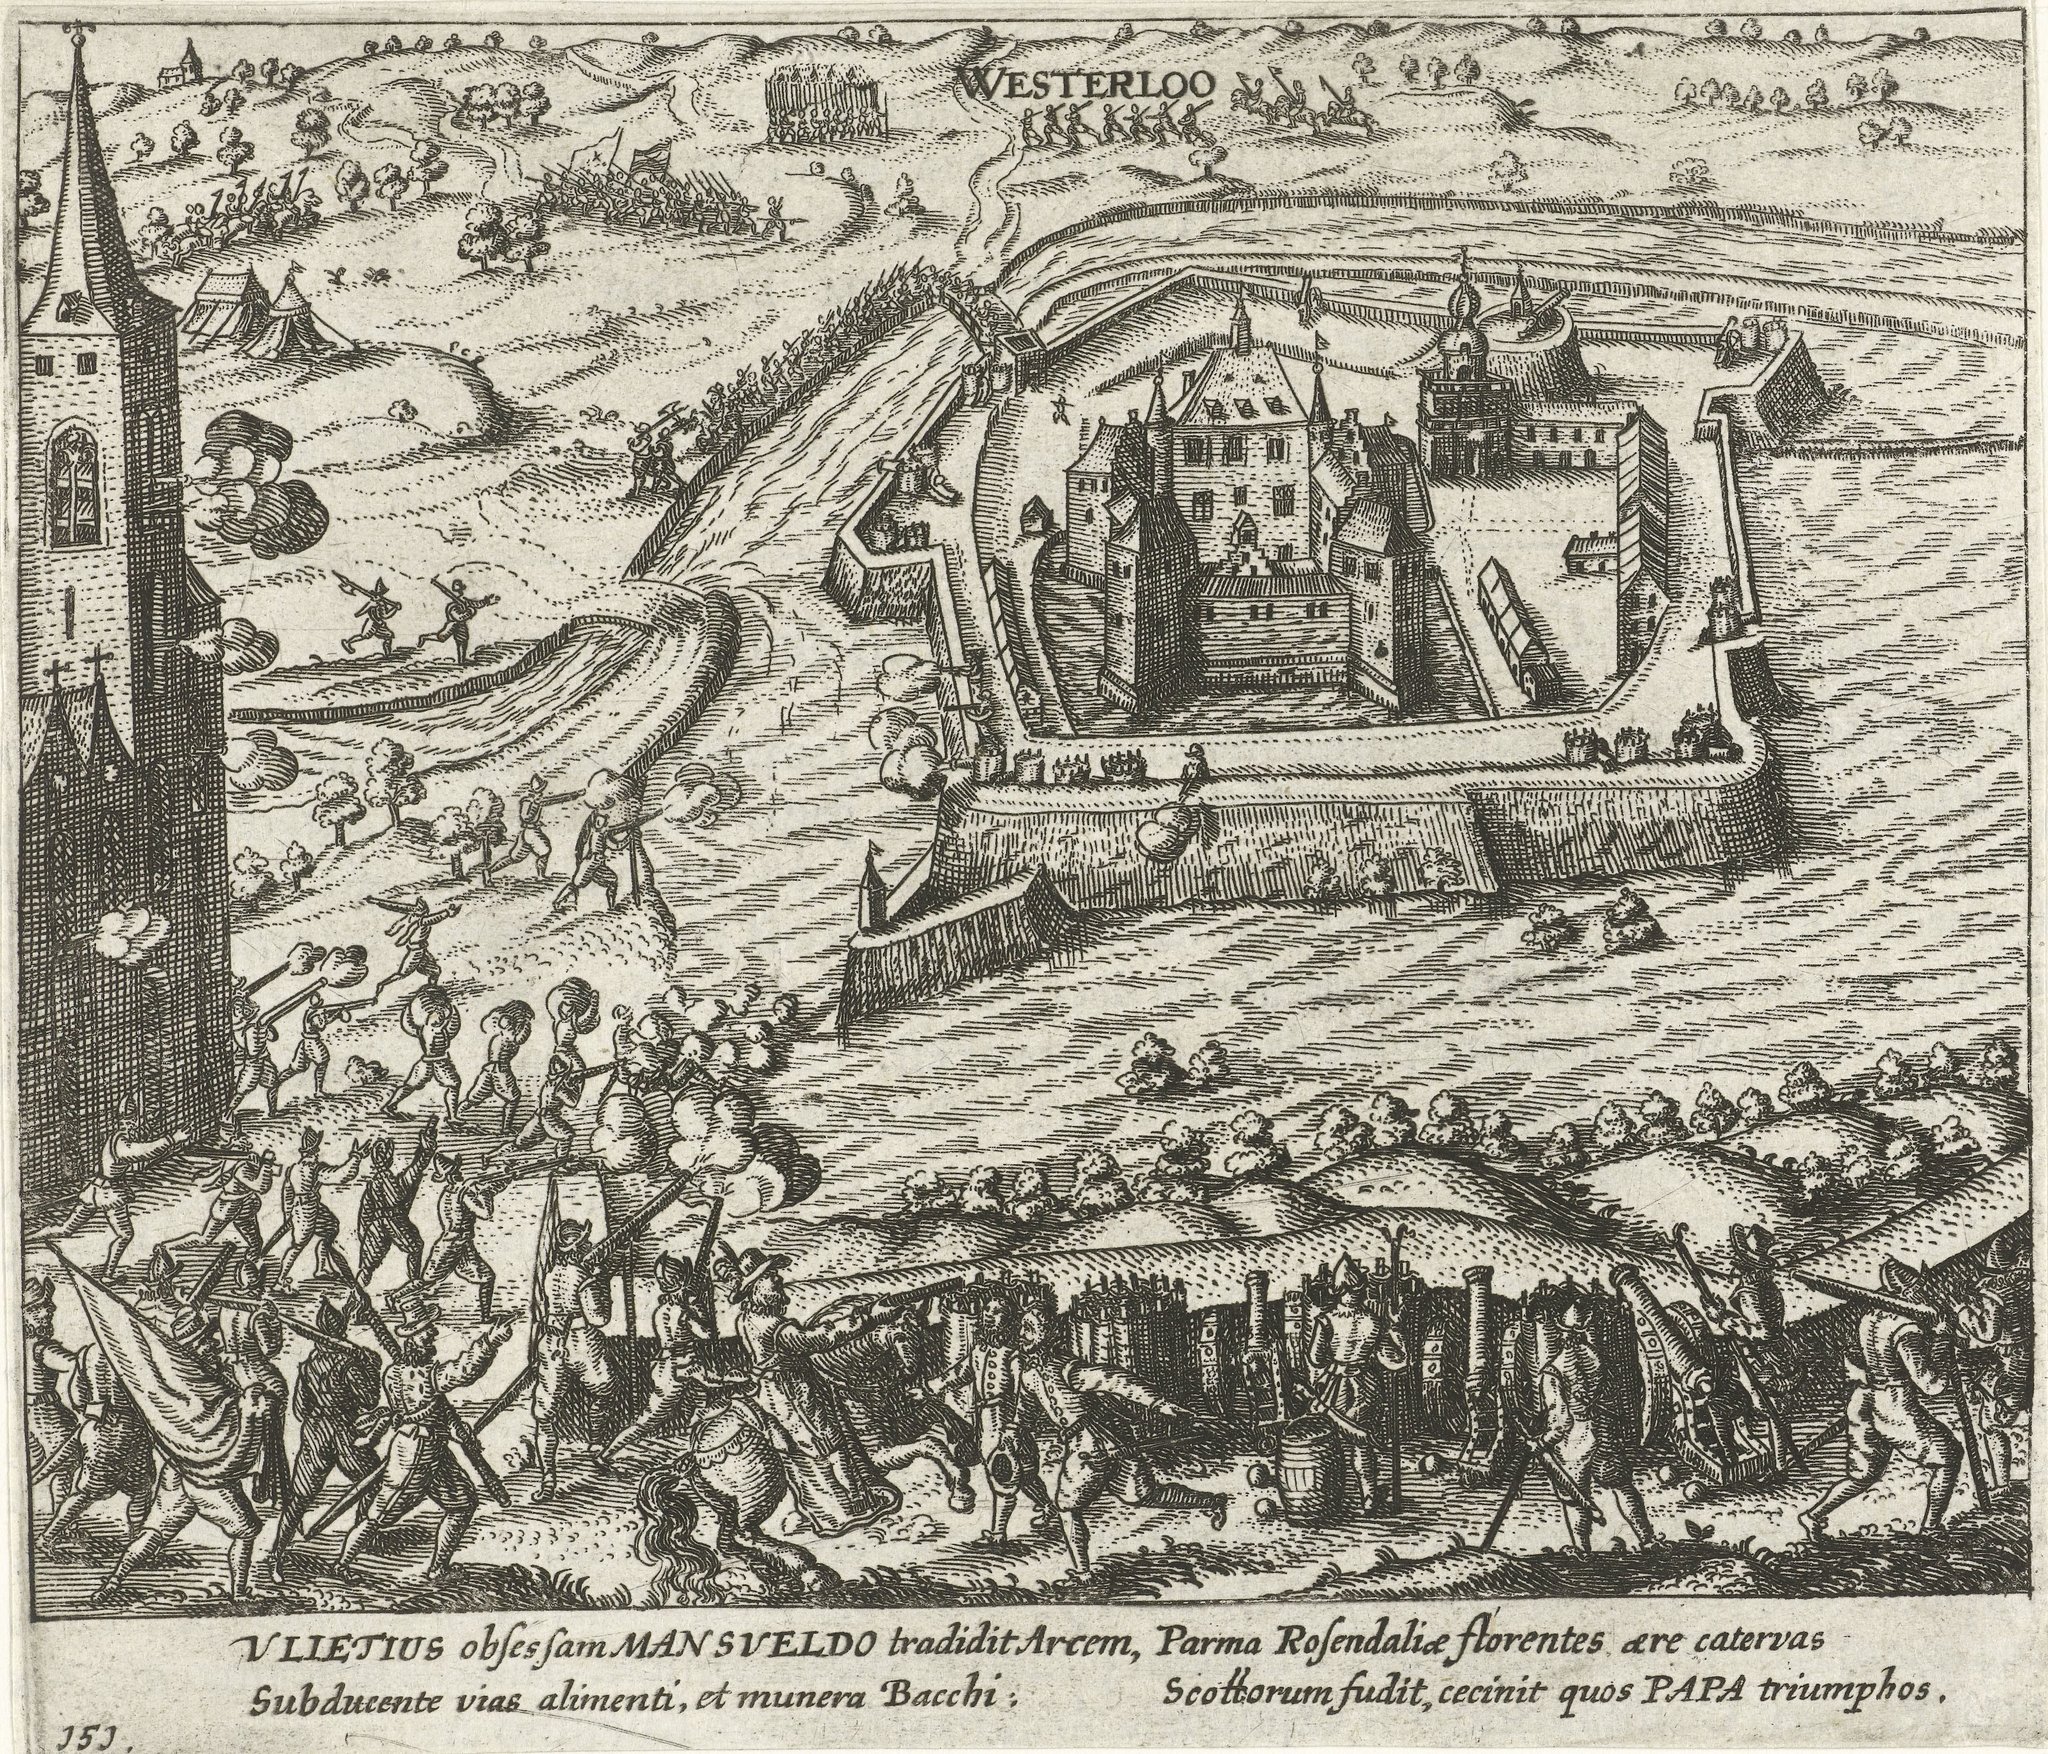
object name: print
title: Kasteel Westerlo veroverd door Mansfeld, 1583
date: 1613-1615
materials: paper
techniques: etching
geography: northern netherlands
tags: siege, position war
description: Het kasteel Westerlo bij Breda beschoten door het leger van de graaf van Mansfeld, 5 juni 1583. Met onderschrift van 4 regels in het Latijn. Genummerd 151. Bedrukt op achterzijde met tekst in het Latijn.